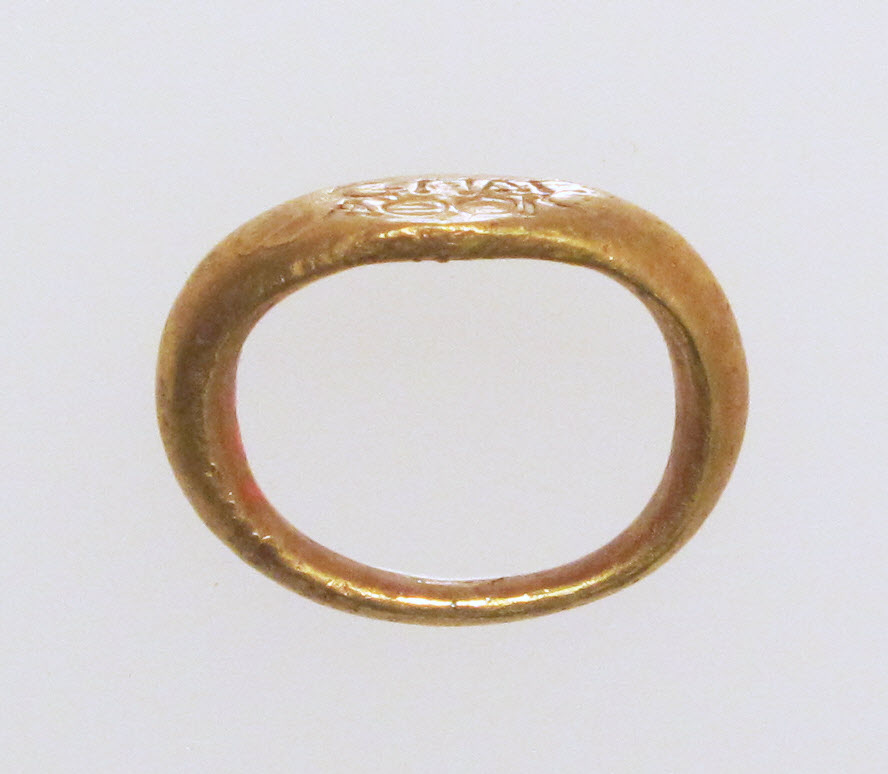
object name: ring, motto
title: Gold ring with inscribed bezel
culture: roman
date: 101-300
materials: gold